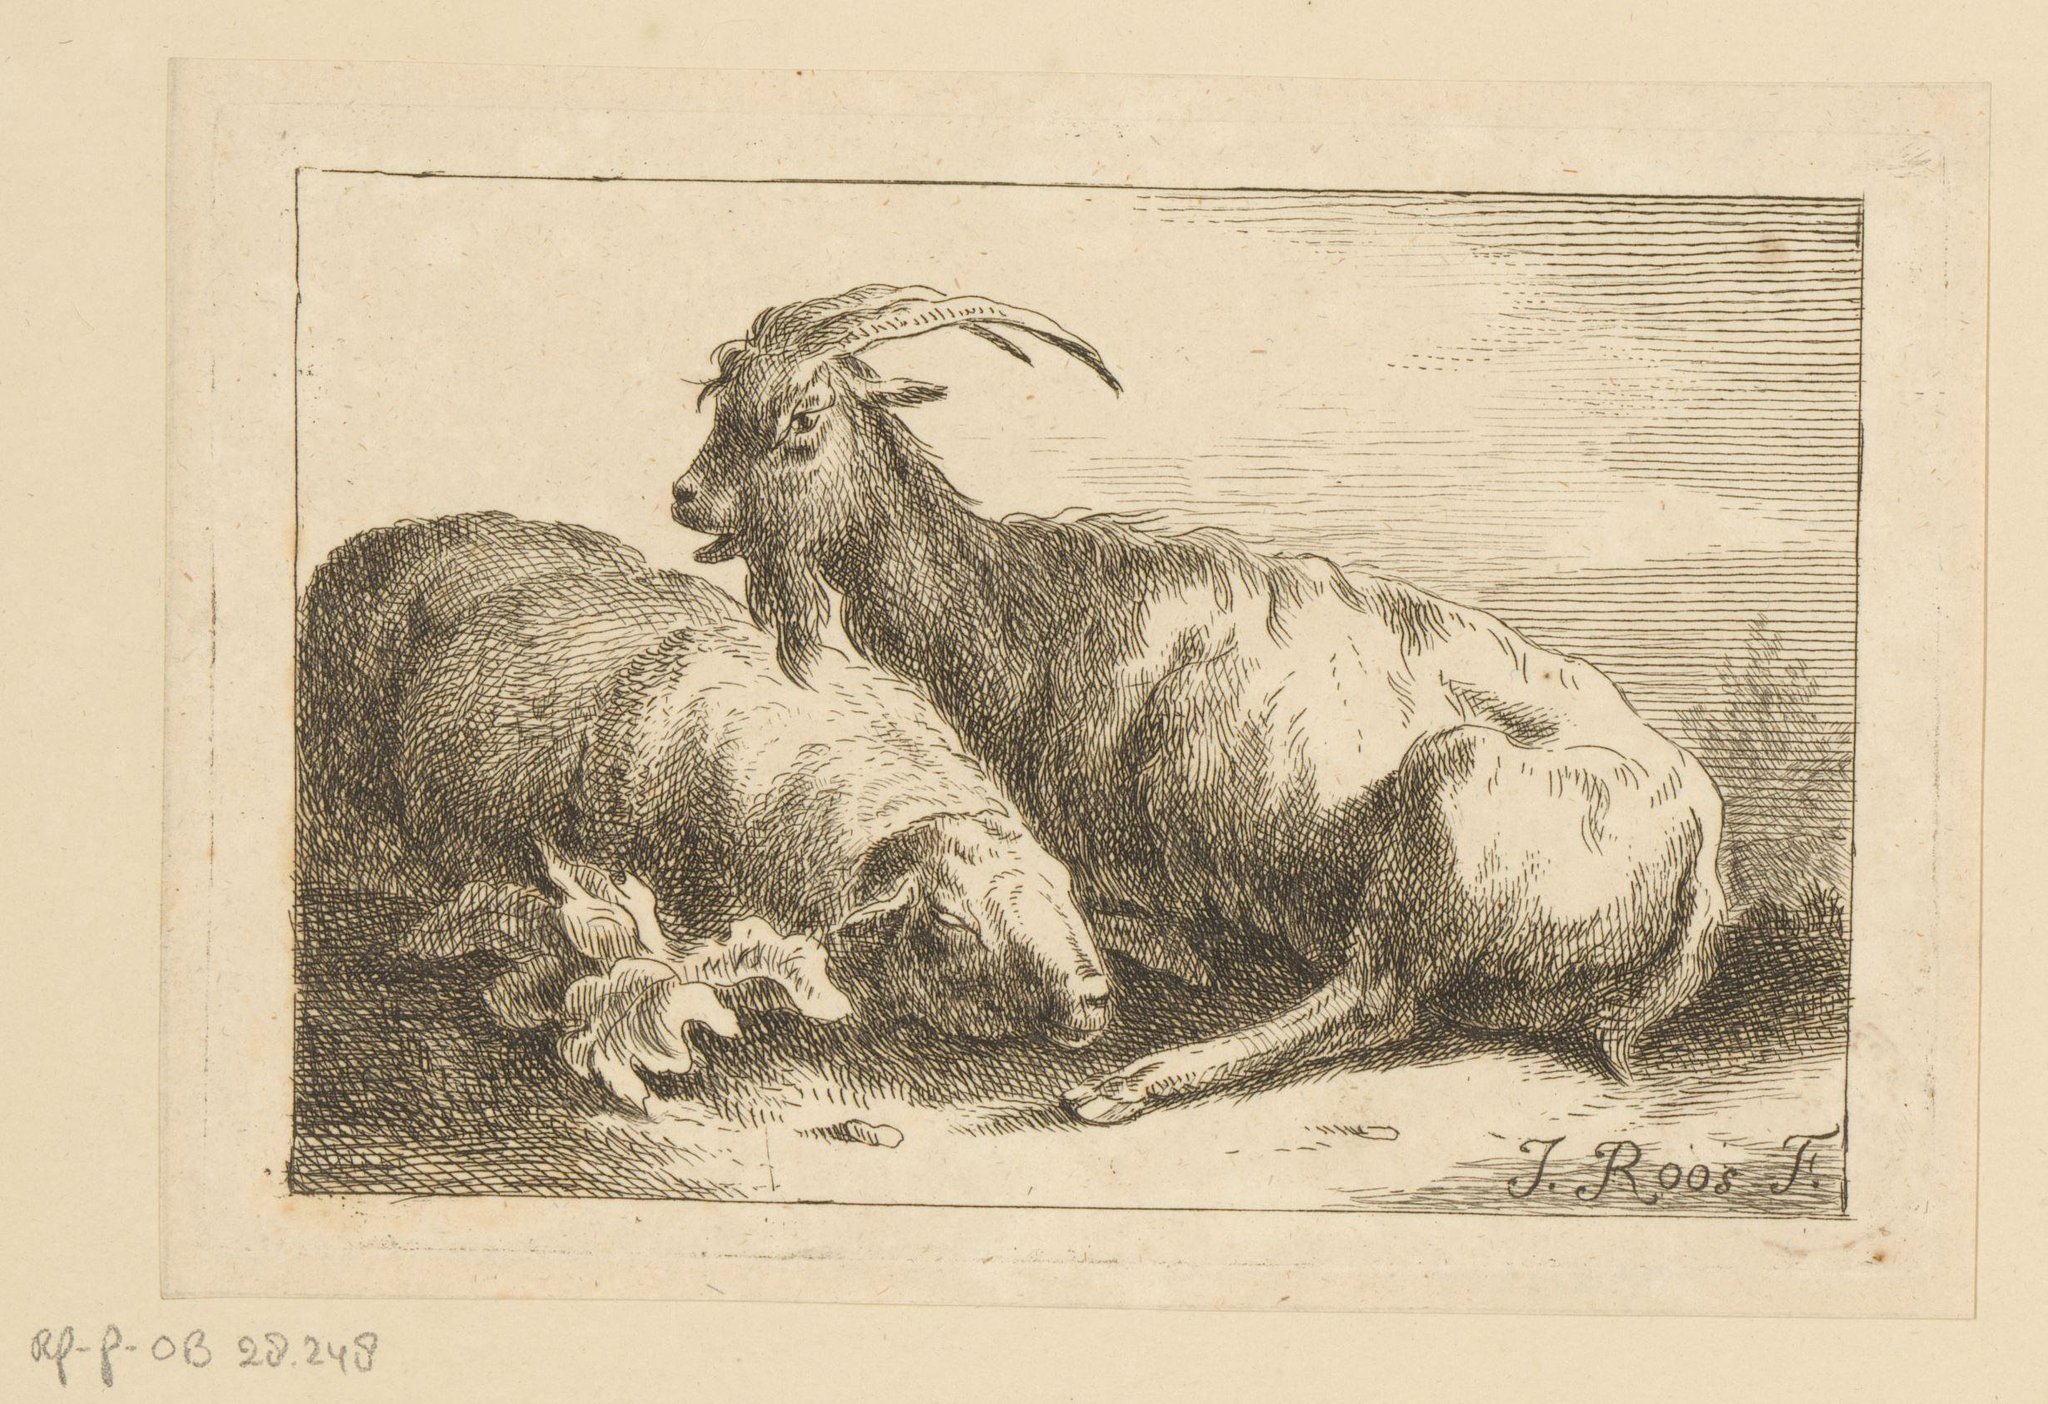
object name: print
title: Geit en een schaap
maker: joseph roos (i)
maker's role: print maker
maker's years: 1726-1805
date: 1754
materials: paper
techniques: etching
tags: landscapes, sheep, goat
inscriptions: collector's mark: Lugt 240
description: Serie van twaalf prenten, waarvan één titelprent.